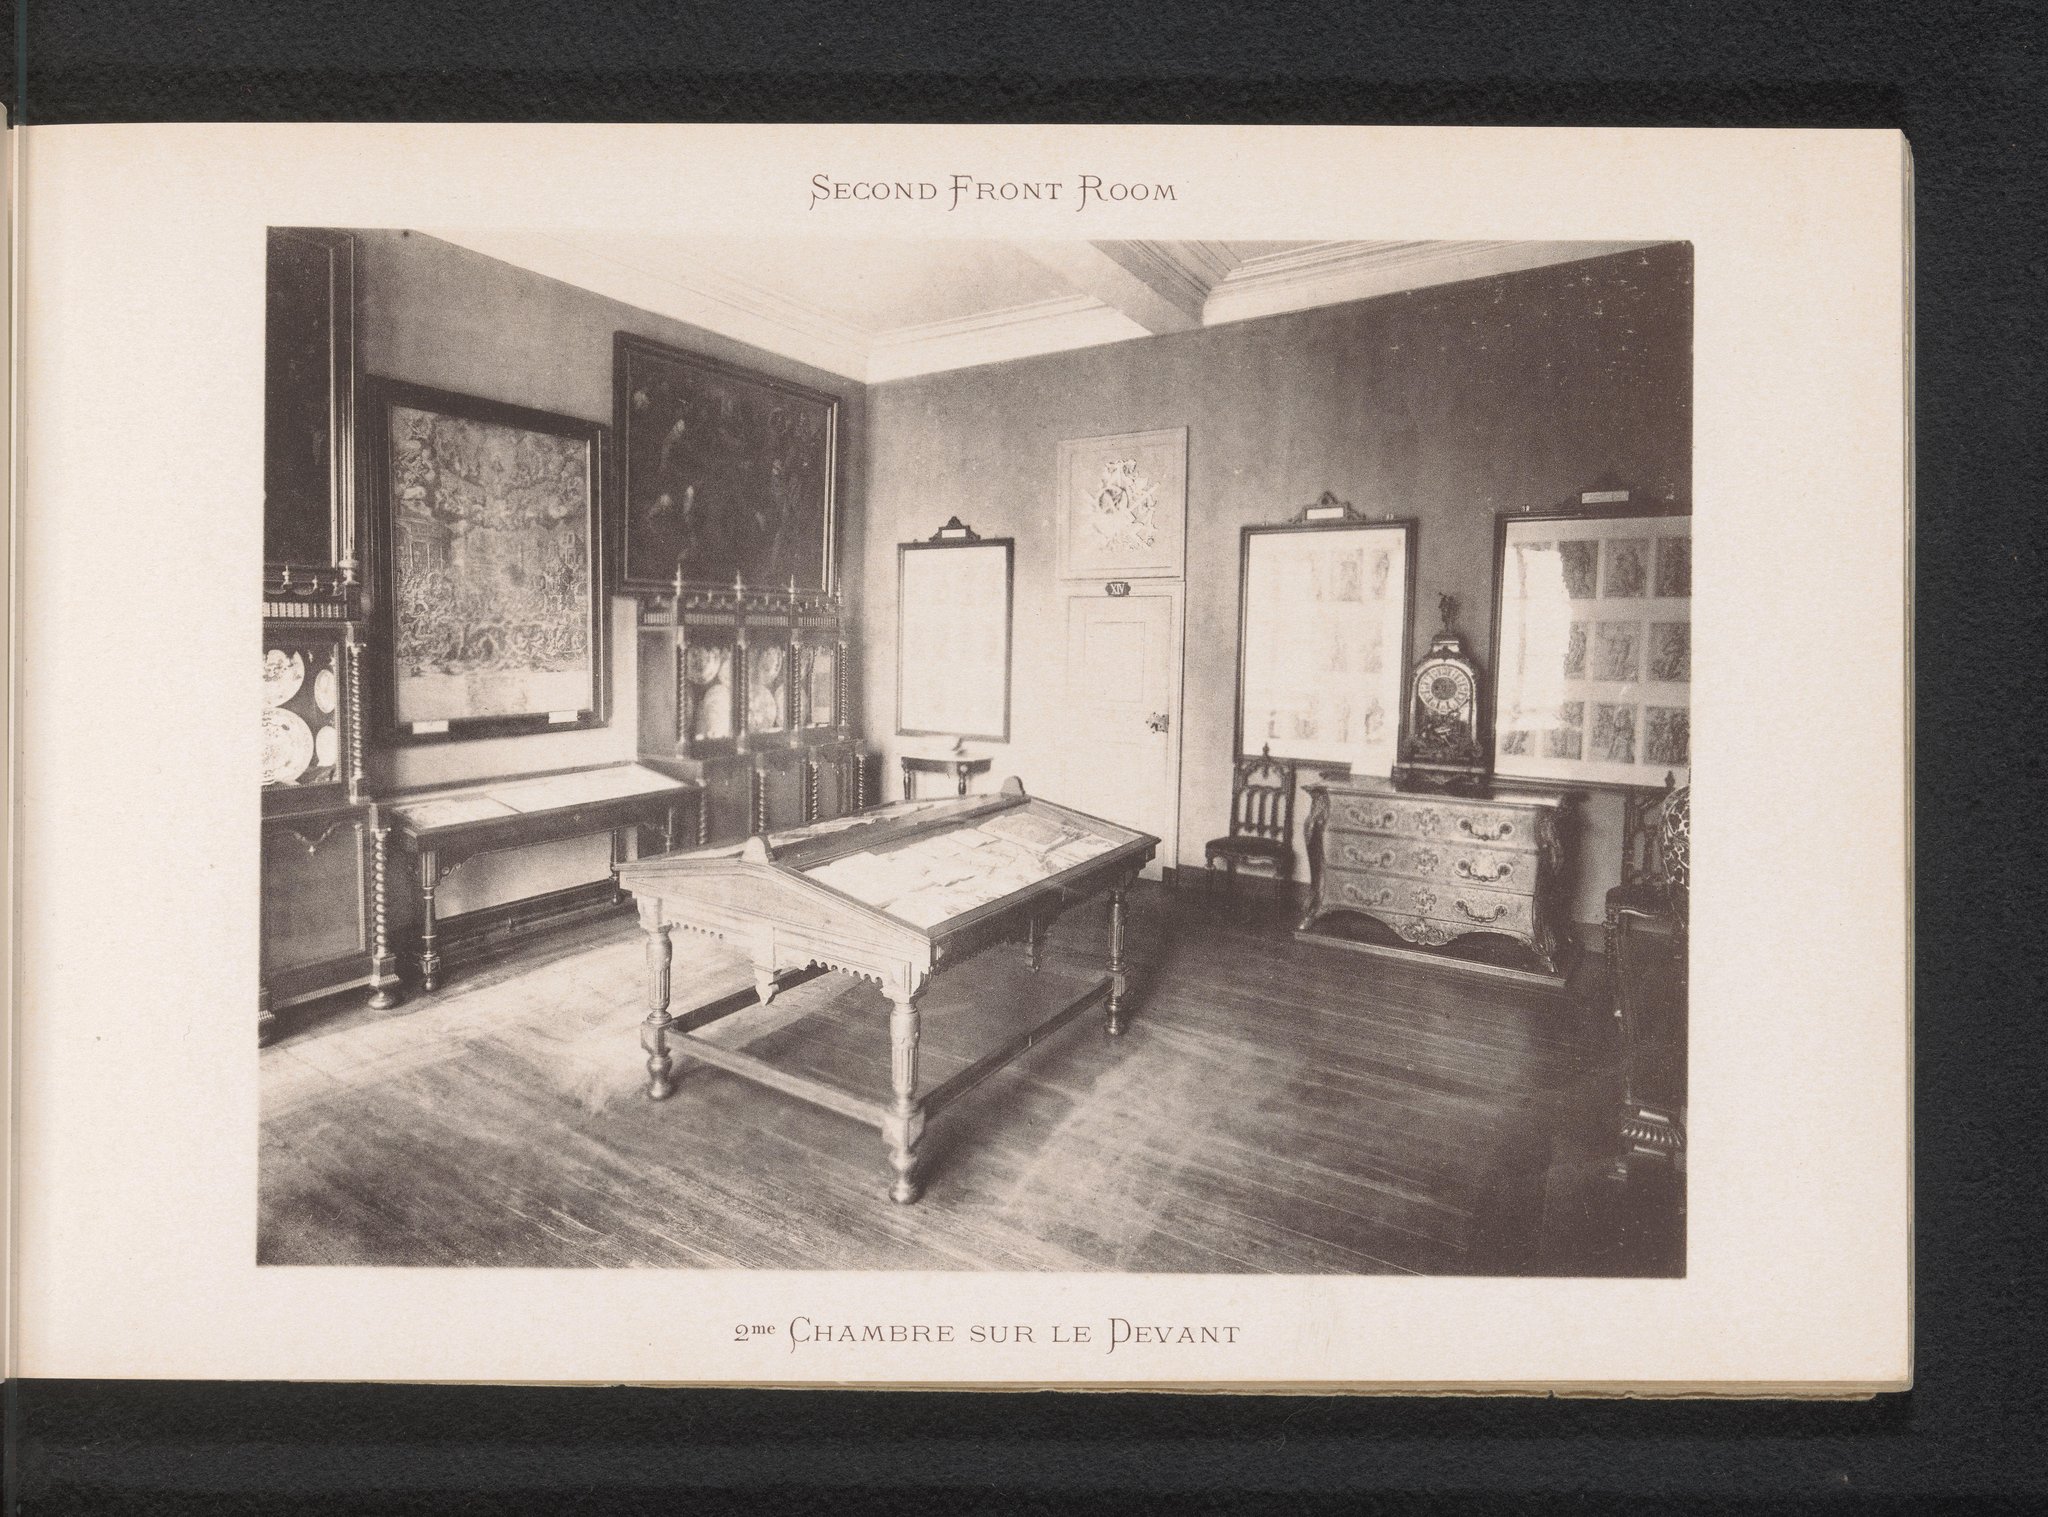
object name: photomechanical print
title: Tweede voorkamer in Museum Plantin-Moretus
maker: Anonymous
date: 1892-1897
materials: paper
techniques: photograph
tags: interior of the house